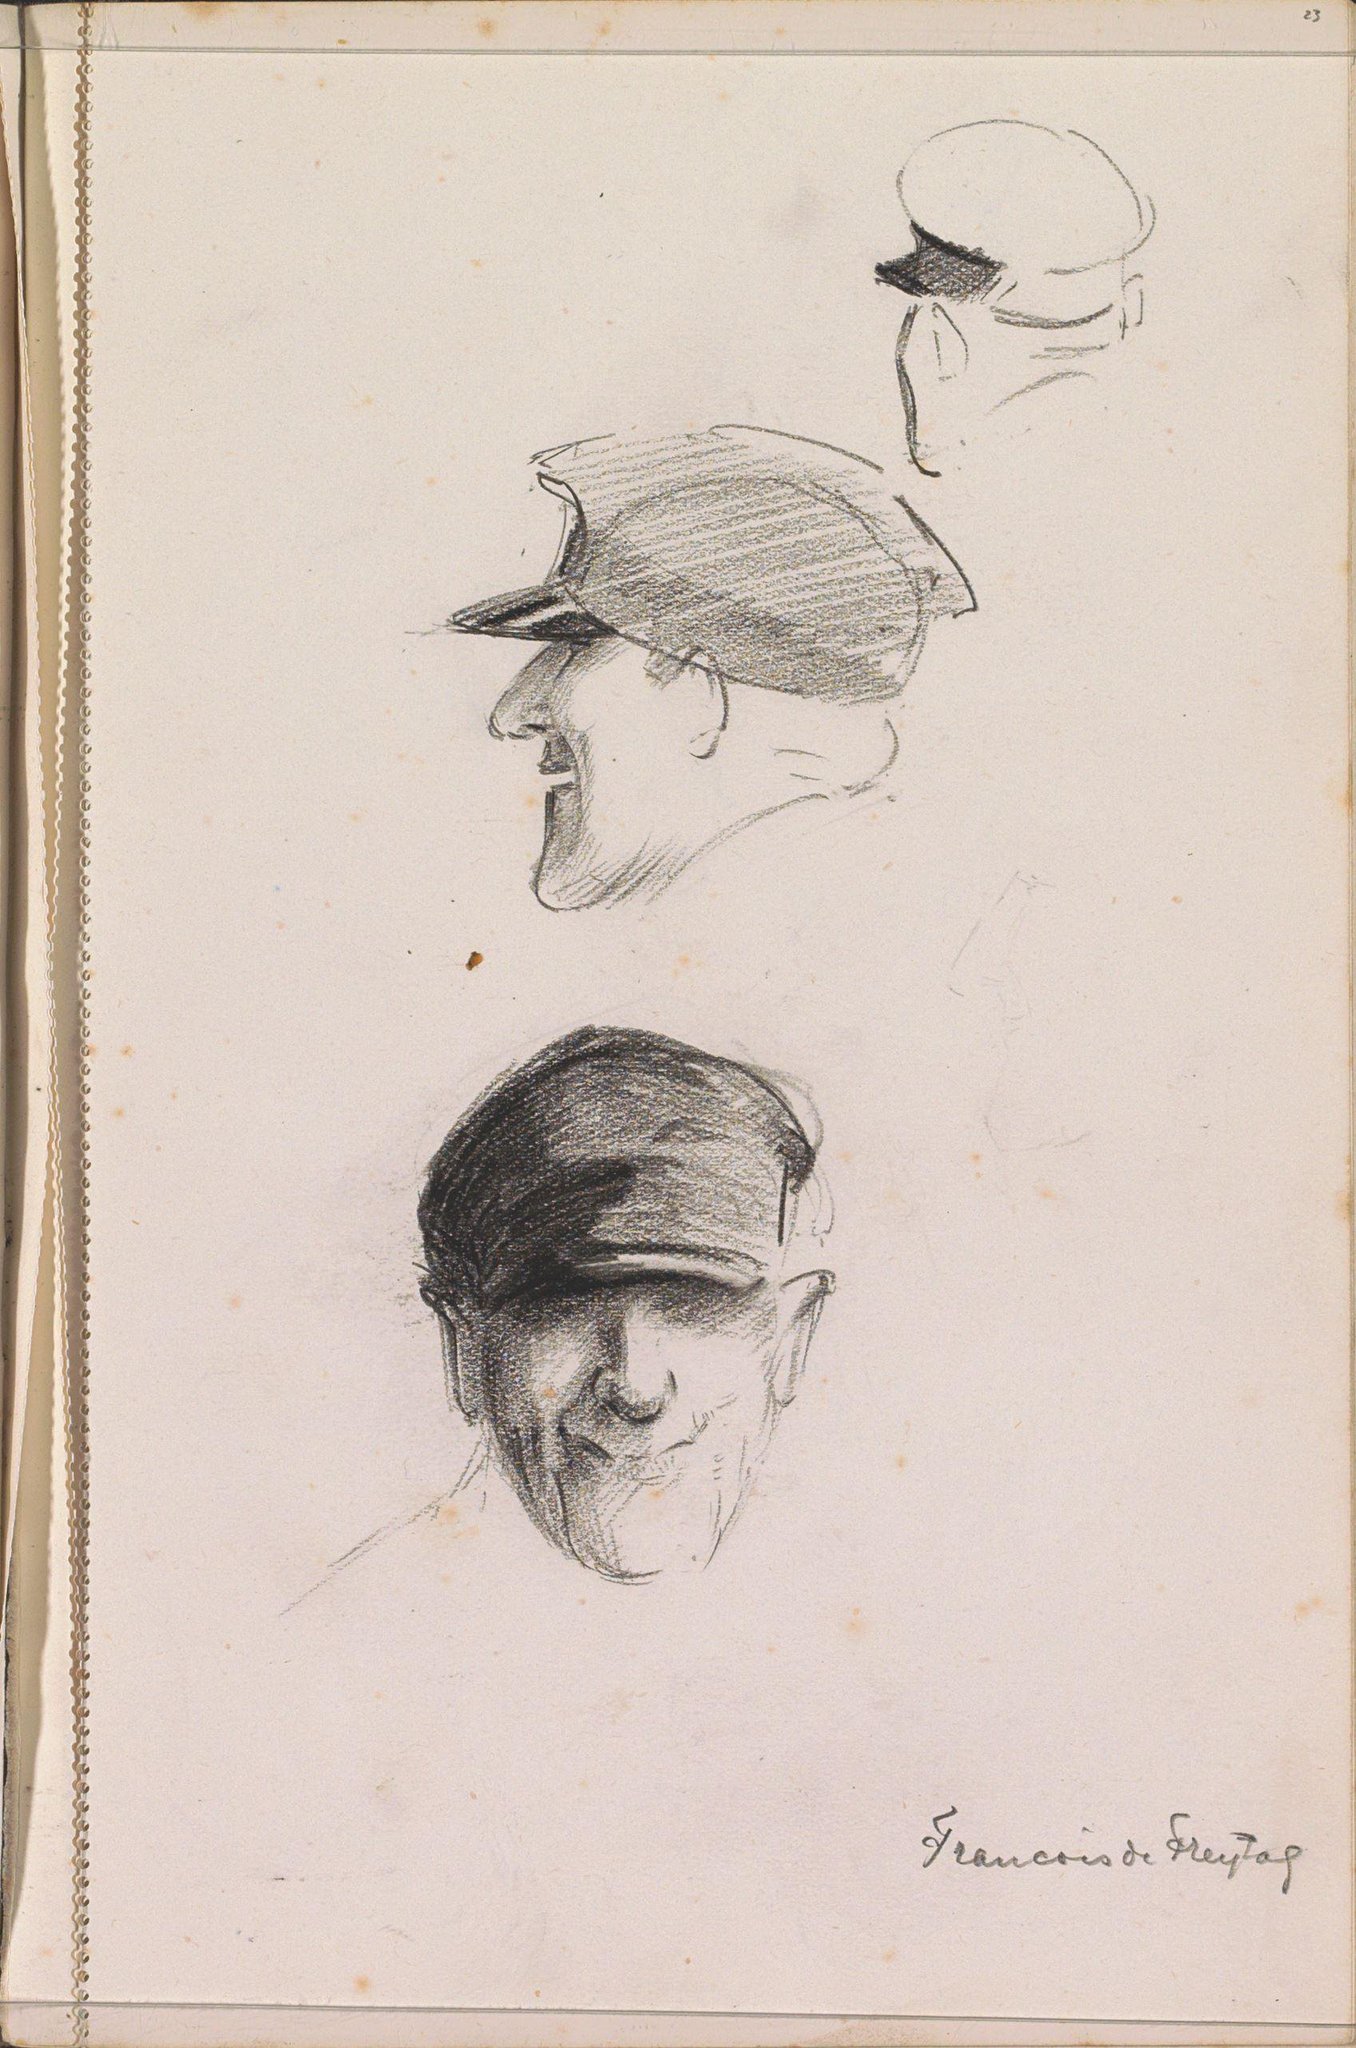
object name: sketchbook leaf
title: Portret van Francois de Freytag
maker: otto verhagen (i)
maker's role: draughtsman, print maker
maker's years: 1885-1951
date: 1922-1925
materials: chalk, paper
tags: head (human), smiling, head-gear: hat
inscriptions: annotation: ‘Francois de Freytag’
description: De man, die uit drie verschillende aanzichten is getekend, draagt een pet en lacht. Pagina 23 uit een schetsboek met 34 bladen.